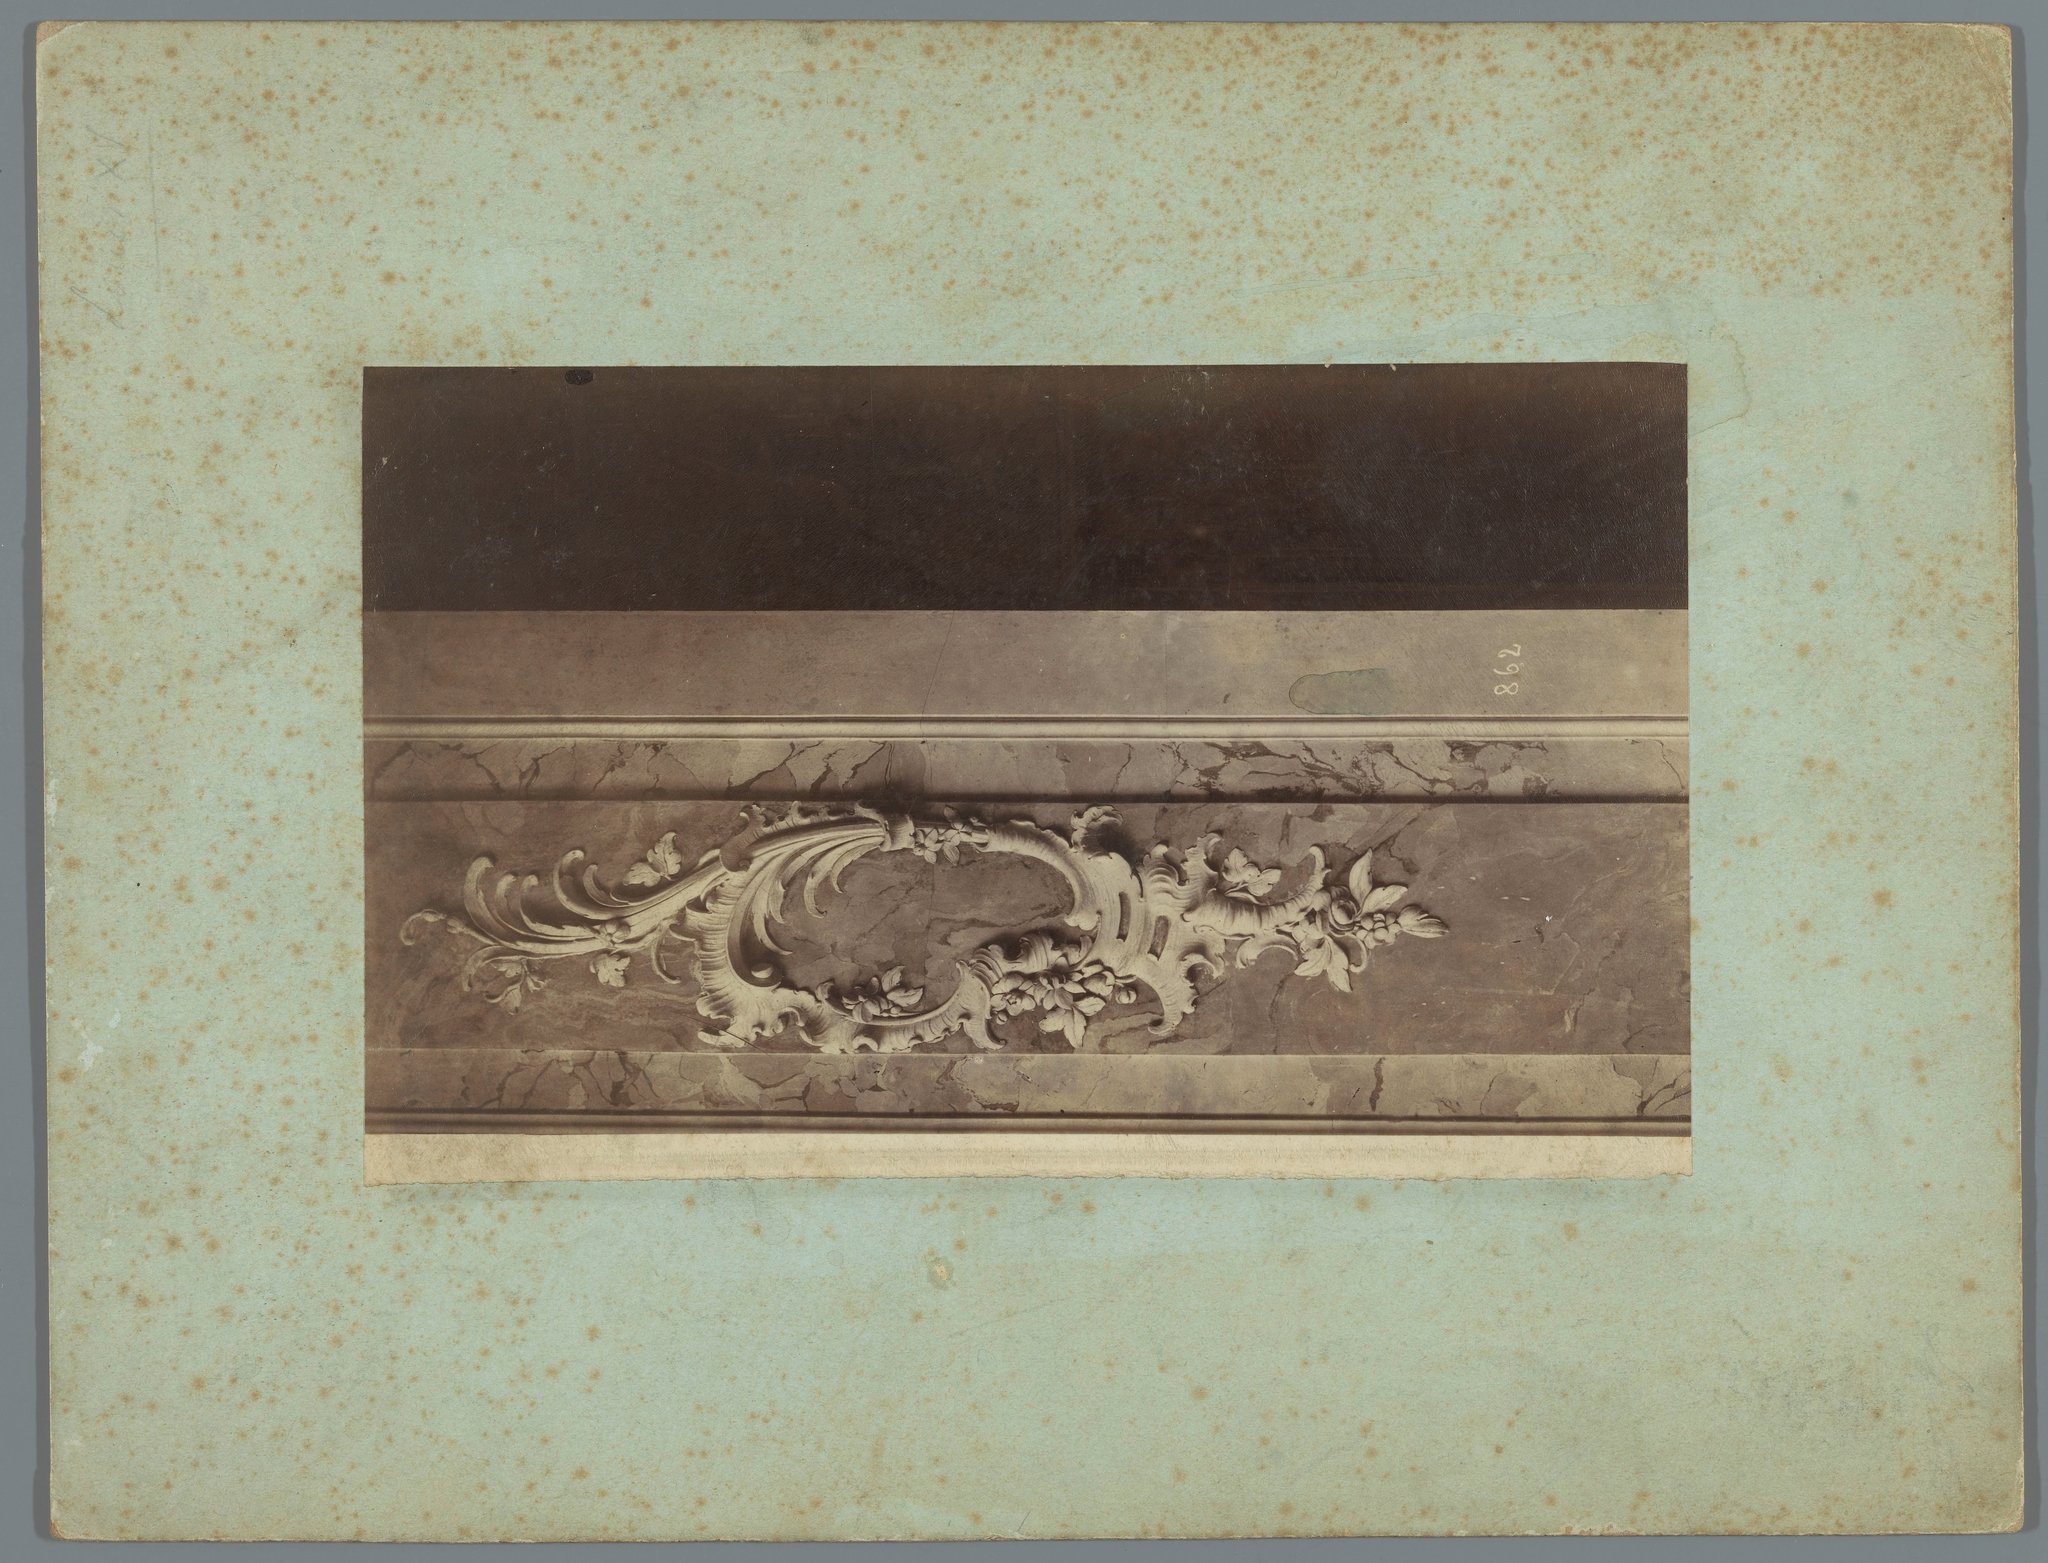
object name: photograph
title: Ornament (vermoedelijk) op een muur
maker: Anonymous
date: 1875-1900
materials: cardboard, photographic support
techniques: albumen print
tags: ornament ~ arabesque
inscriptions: inscription: ‘pl 18’, number: ‘862’, collector's mark: Lugt 3937